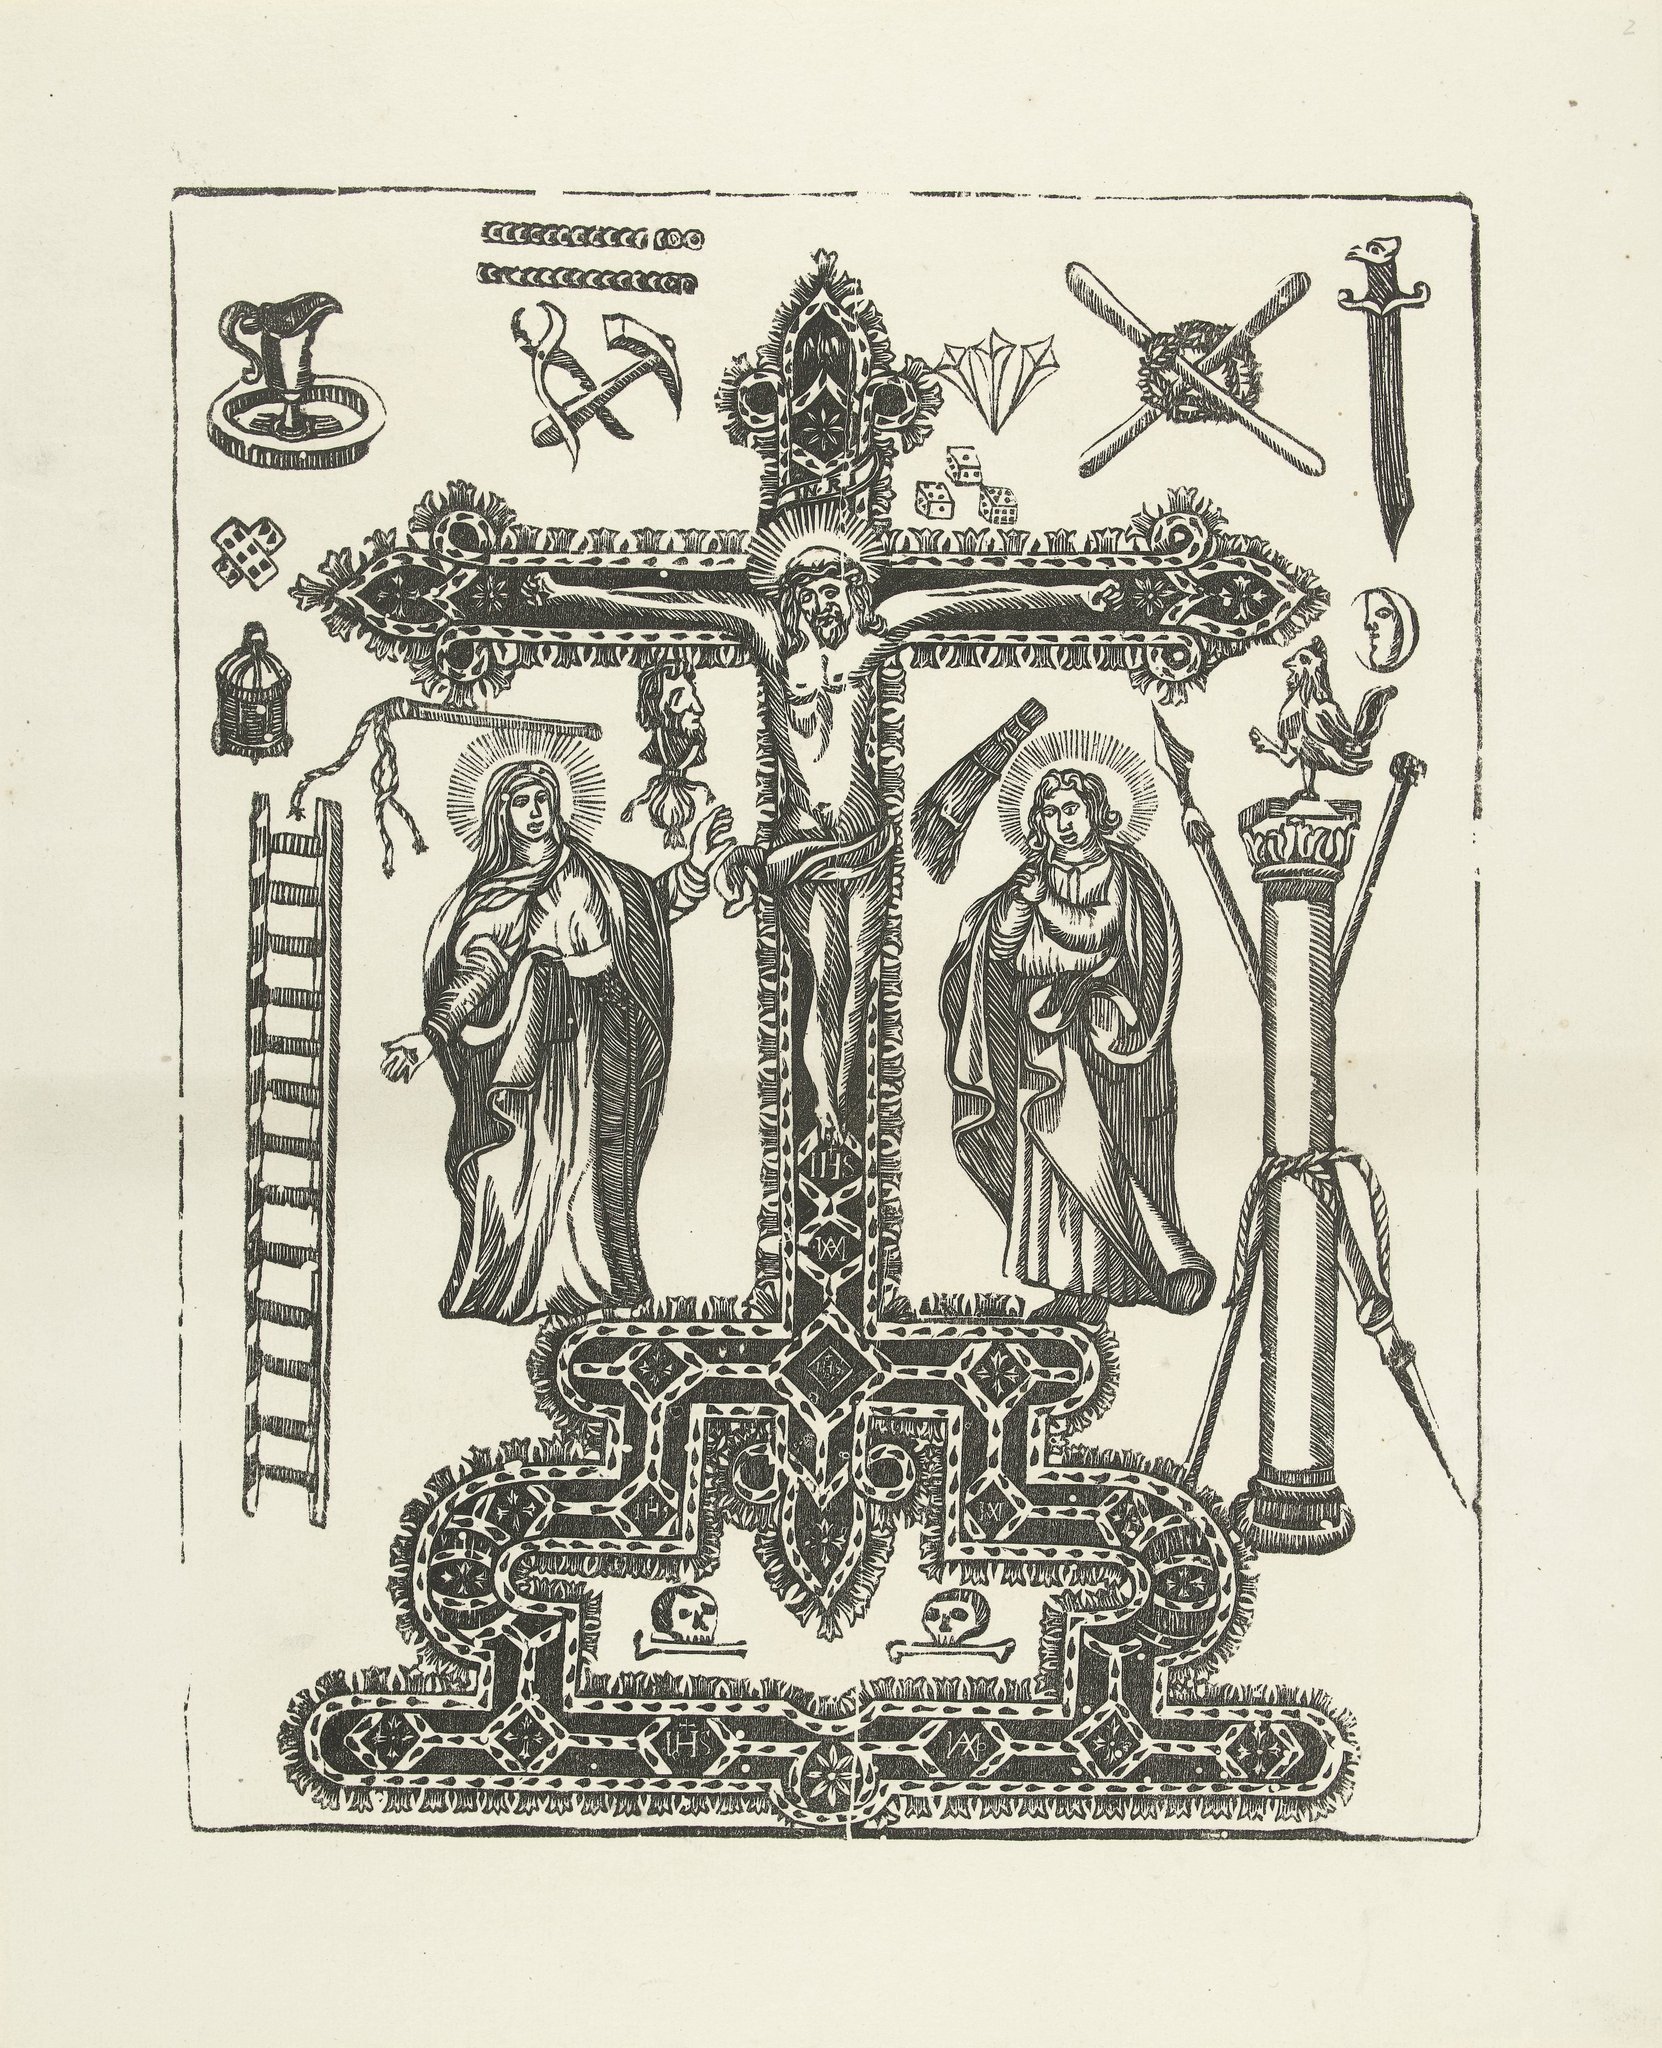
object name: popular print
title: Kruisbeeld en passieinstrumenten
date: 1700-1725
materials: paper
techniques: woodcut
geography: ghent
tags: altarcross, crucifix, the instruments of the passion and the five wounded limbs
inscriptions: collector's mark: Lugt 2760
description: Een met juwelen bezet kruisbeeld van Christus aan het kruis met links Maria en rechts Johannes, omringd door de instrumenten van de passie.